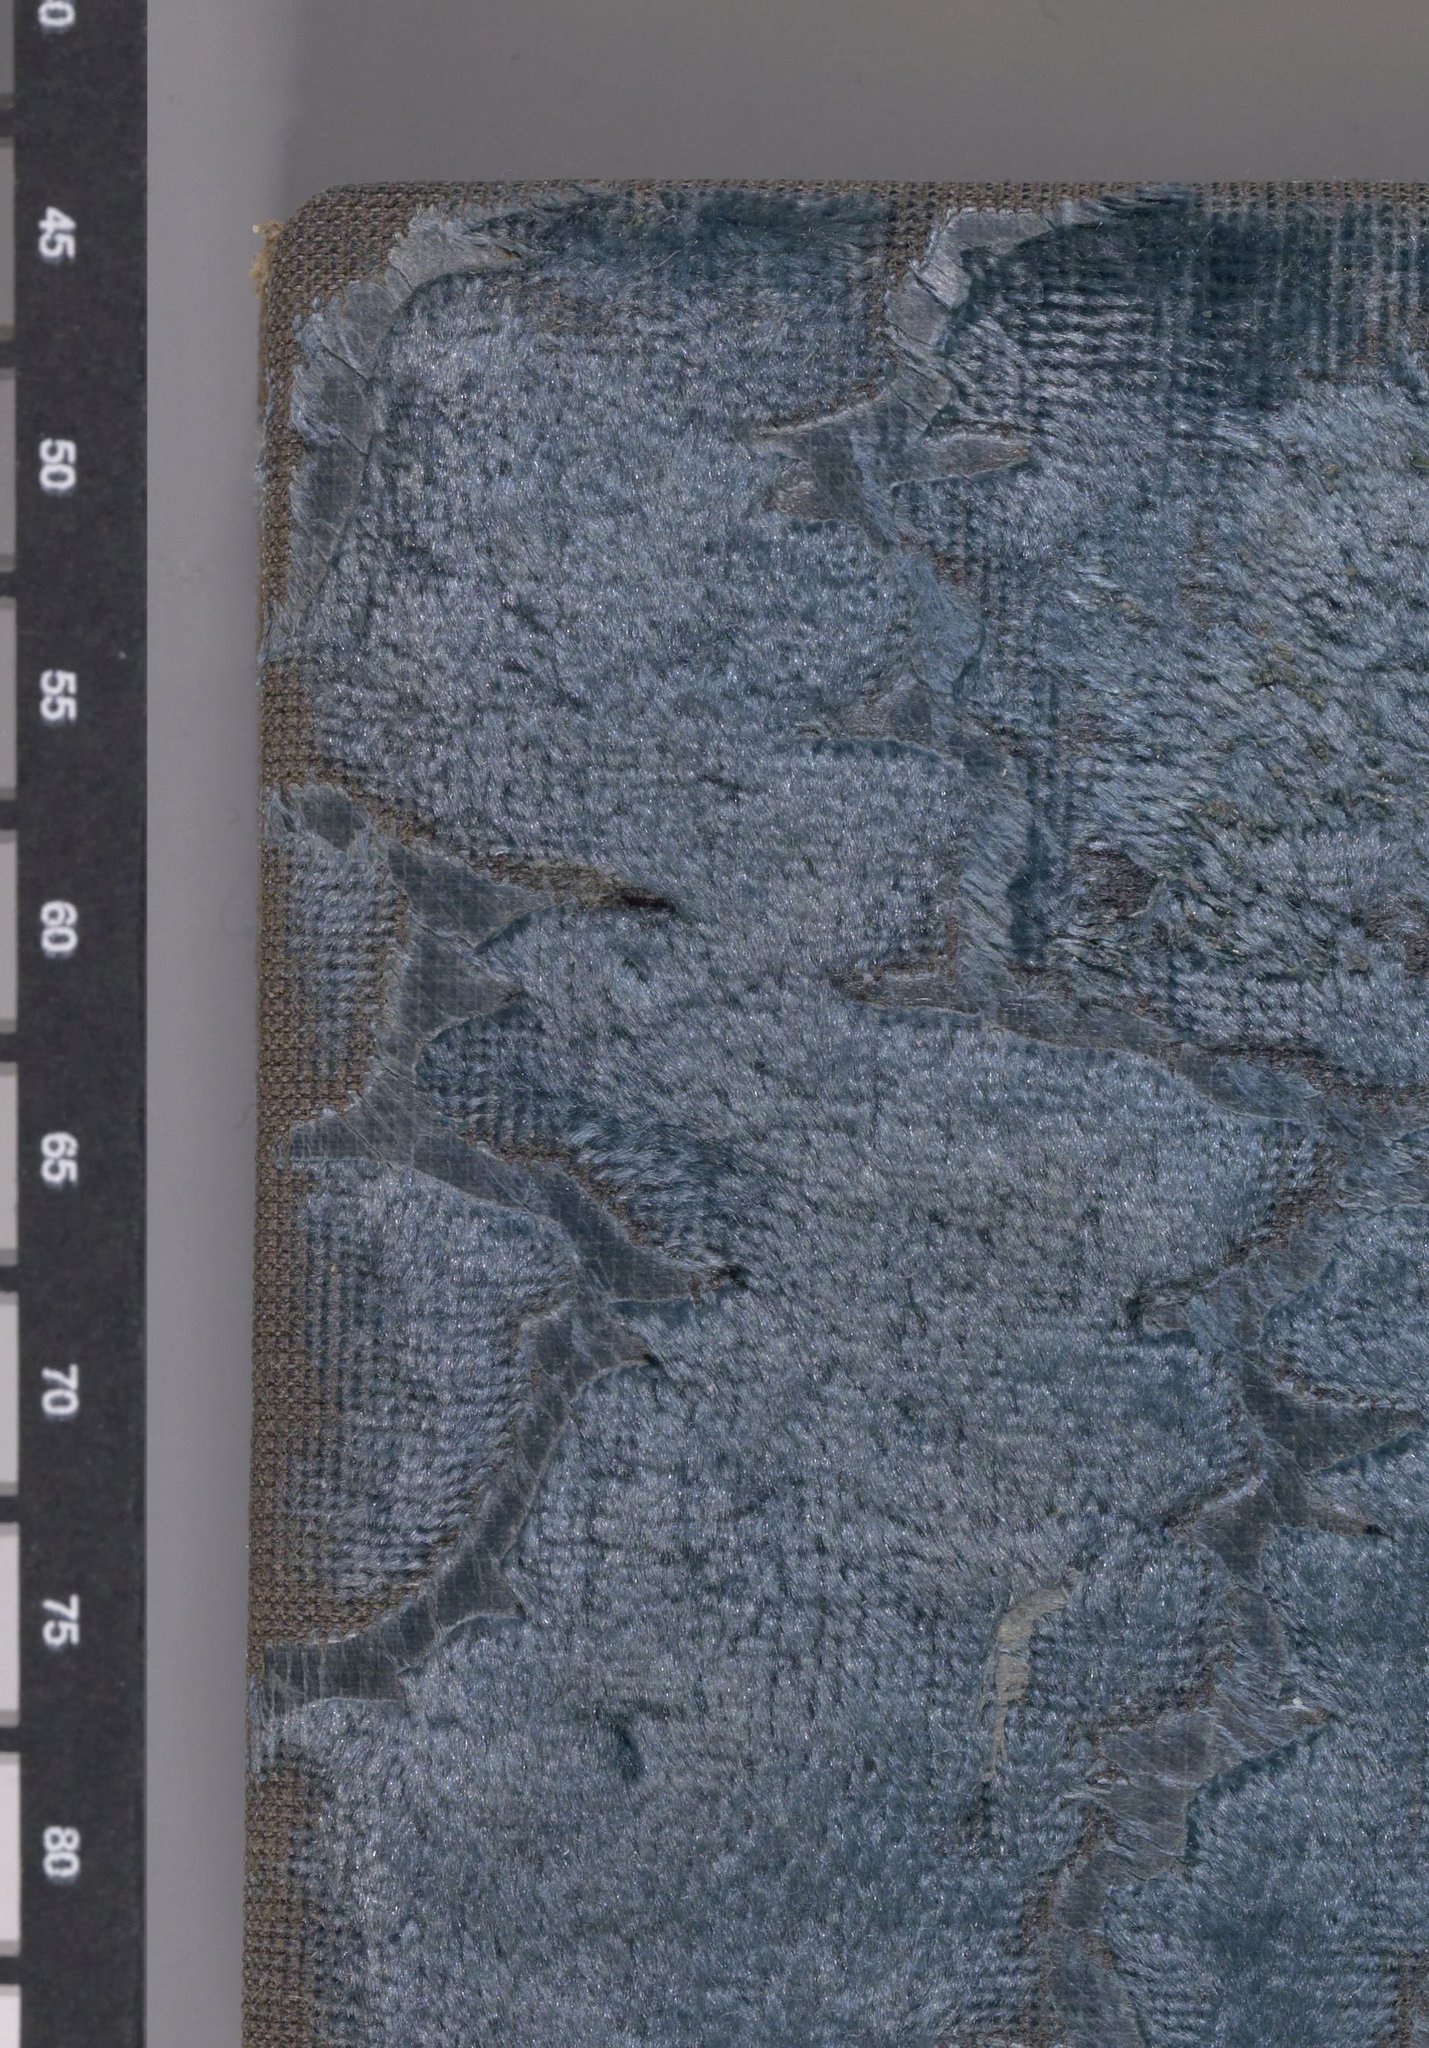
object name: photograph album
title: Fotoalbum in blauw pluche voor zes afdrukken (leeg)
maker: Anonymous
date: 1860-1900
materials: cardboard, linen, paper, textile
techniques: bookbinding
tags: book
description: Fotoalbum met voor- en achterplat van blauw pluche. Het heeft vier kartonnen bladen met goud op snee, die met een linnen band aan elkaar verbonden zijn. Het album heeft zes passe-partouts voor foto's van ca. zes bij vier centimeter. Twee passe-partouts hebben een achterzijde van gegaufreerd papier met een bloemmotief. Het leporelloalbum kan doorgebladerd worden, maar ook uitgeklapt rechtop gezet worden.